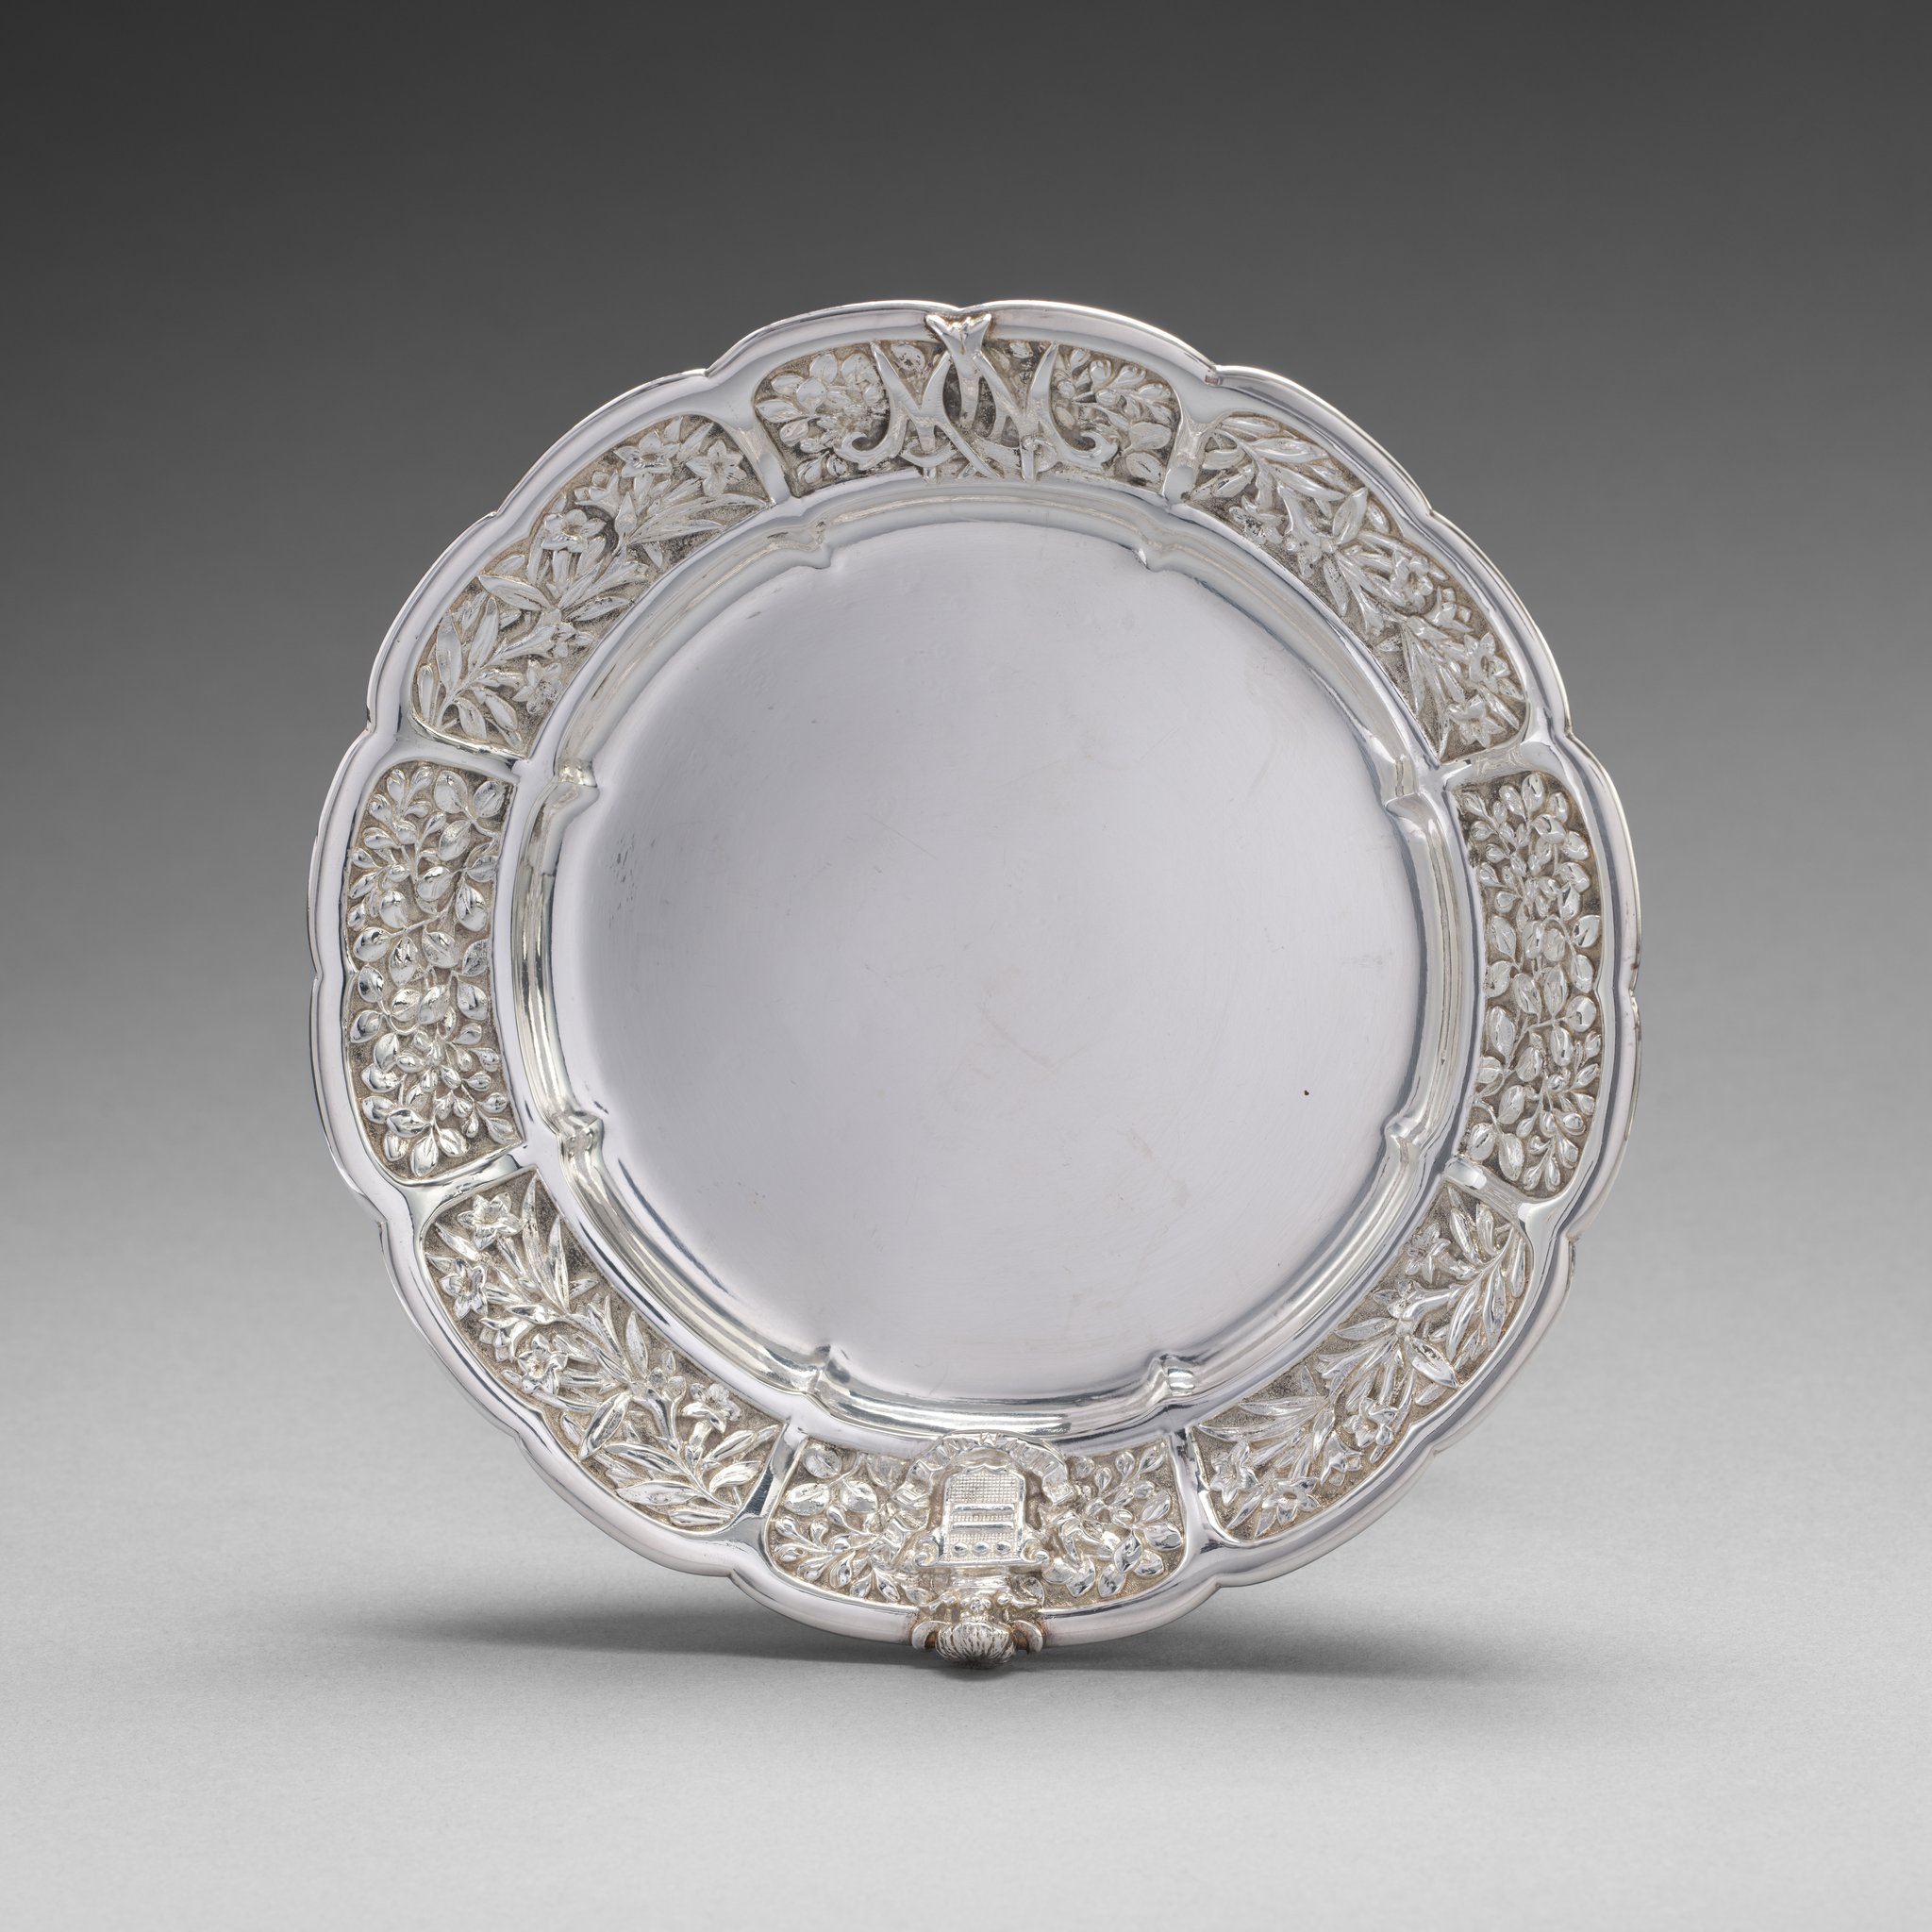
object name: ice cream plate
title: Ice Cream Plate from Mackay Service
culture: american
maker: tiffany & co.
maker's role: maker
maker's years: 1837-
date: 1878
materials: silver